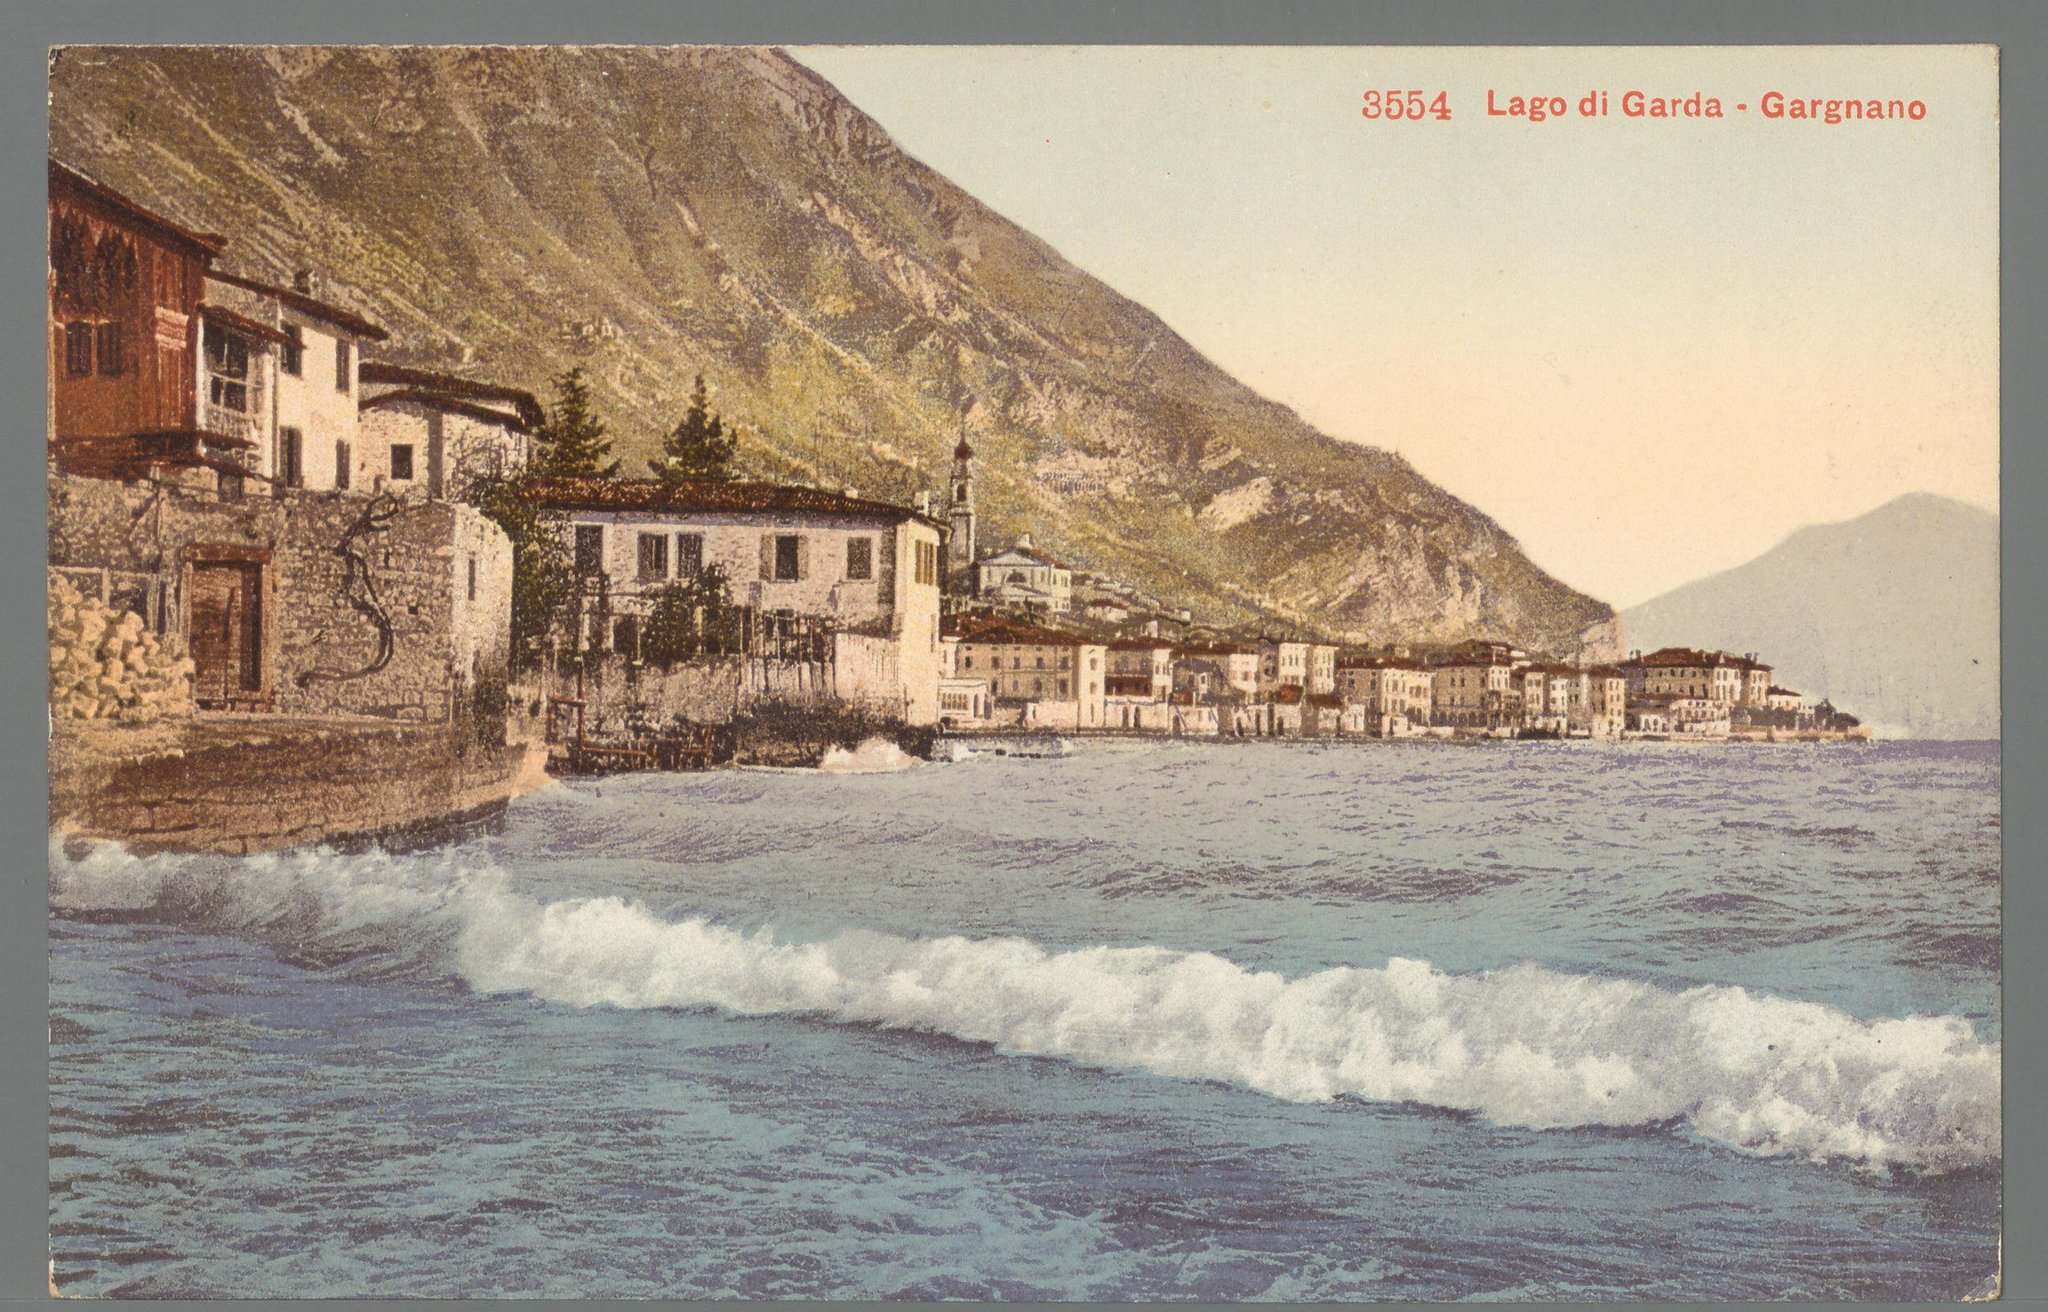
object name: photomechanical print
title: Lago di Garda. Gargnano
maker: Anonymous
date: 1905-1930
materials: cardboard, photographic process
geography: gargnano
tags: prospect of village, silhouette of village, lake, mountains